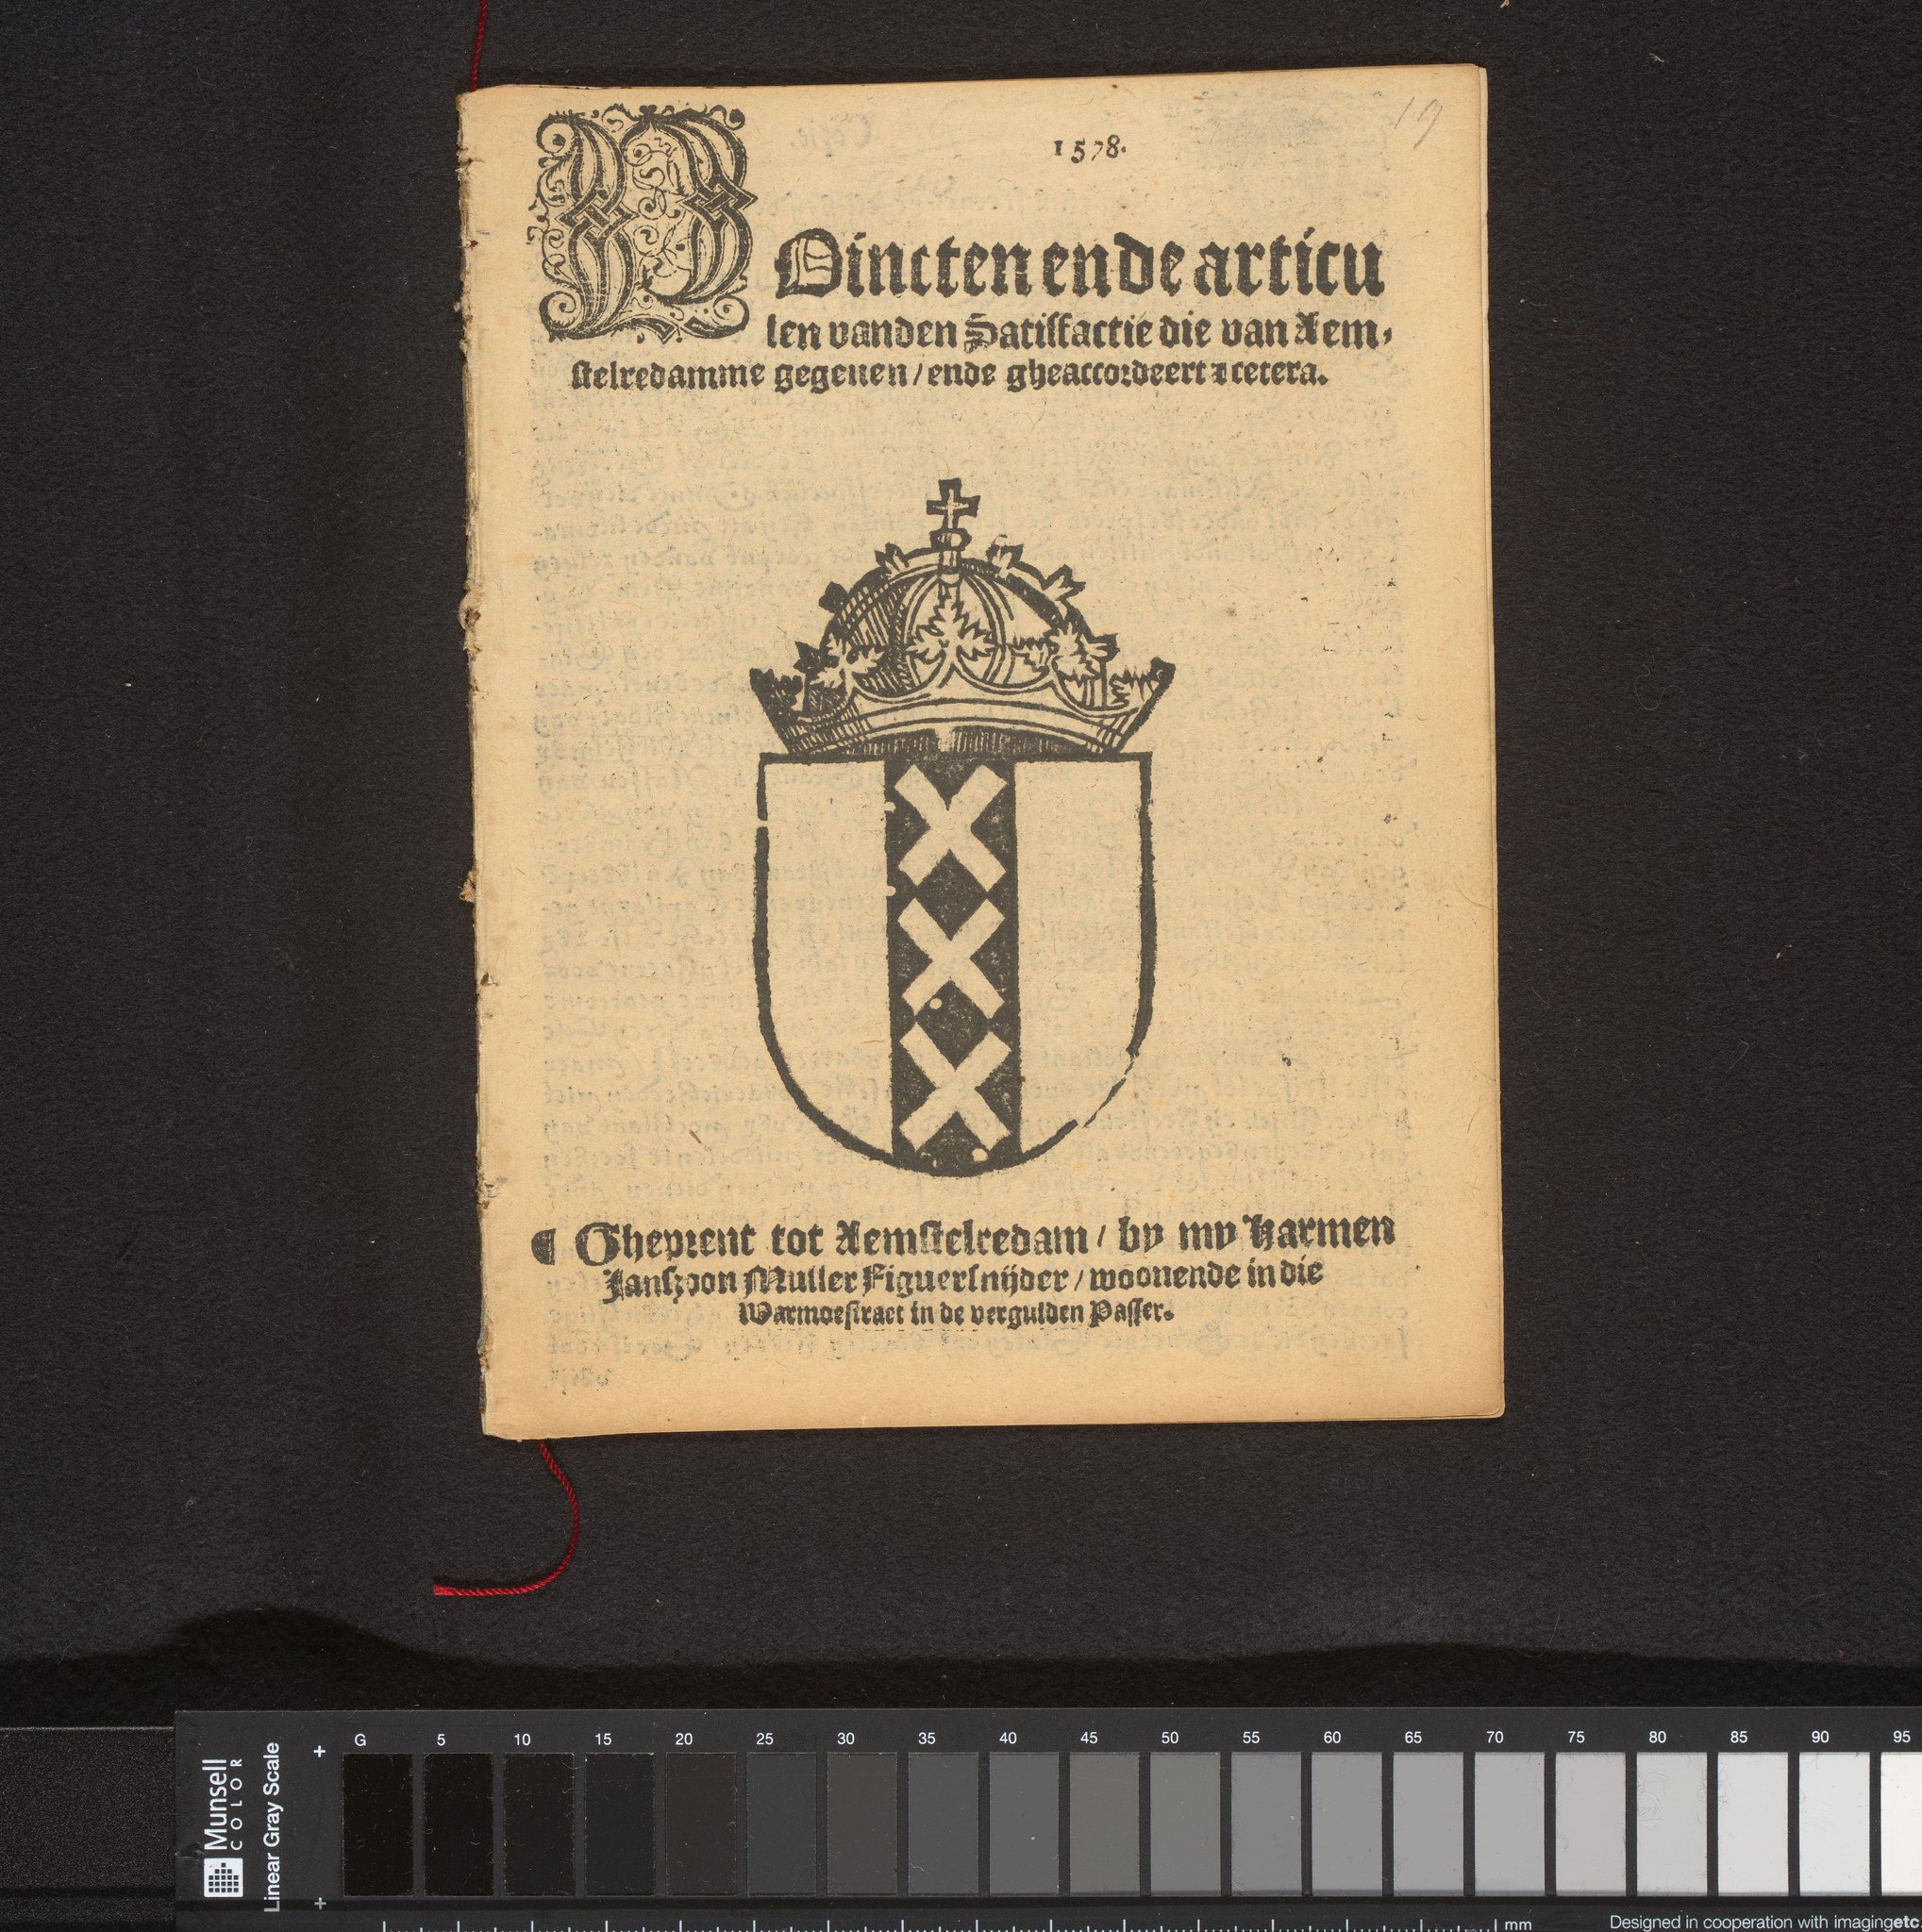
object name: pamphlet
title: Pointcen en de articulen van den Satisfactie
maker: harmen jansz muller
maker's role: print maker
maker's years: 1540-1617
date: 1578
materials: cordage, paper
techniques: brocade, printing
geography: amsterdam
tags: amsterdam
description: Titelpagina: opschrift beginnend met grote, bewerkte letter P. Daaronder gekroond wapen van Amsterdam. Pagina's aan beide zijden vol bedrukt. Opschrift: Poincten ende articulen van den Satisfactie die van Aemstelredamme gegeven / ende gheaccordeert etcetera.